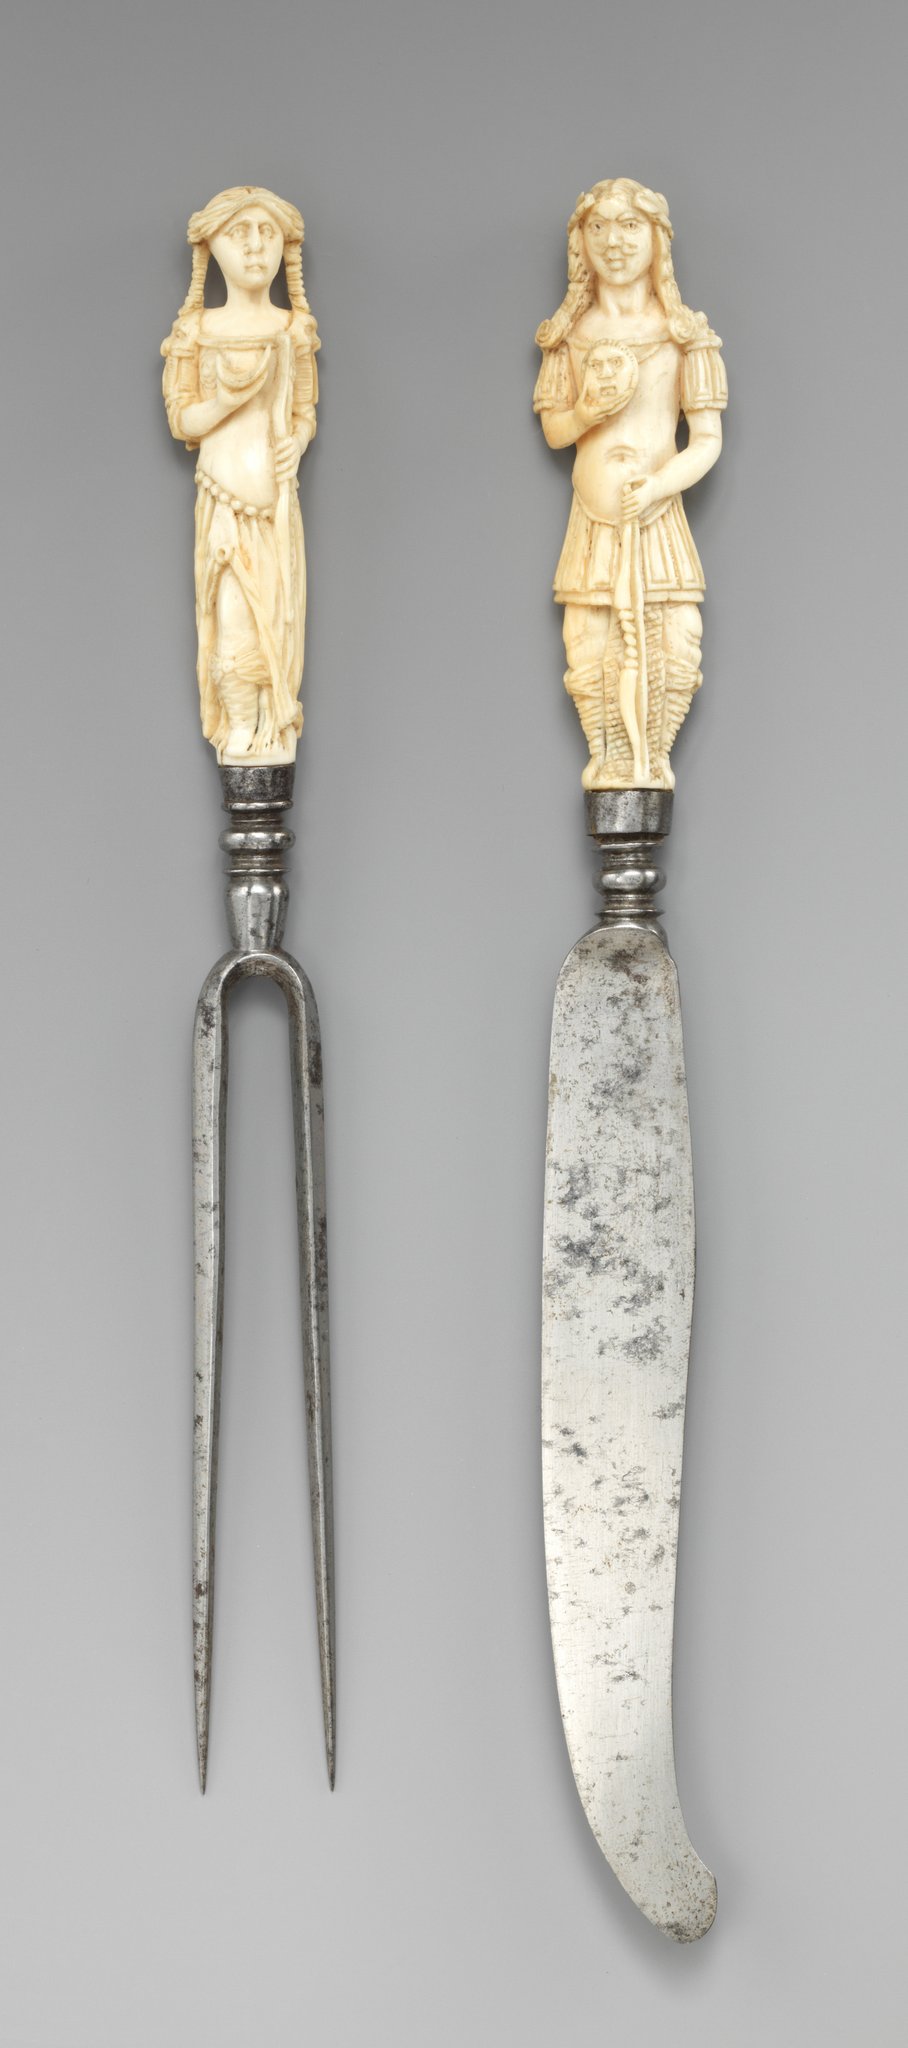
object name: fork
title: Fork with carved handle in the form of Diana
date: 1767-1800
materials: ivory, steel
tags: apollo,diana